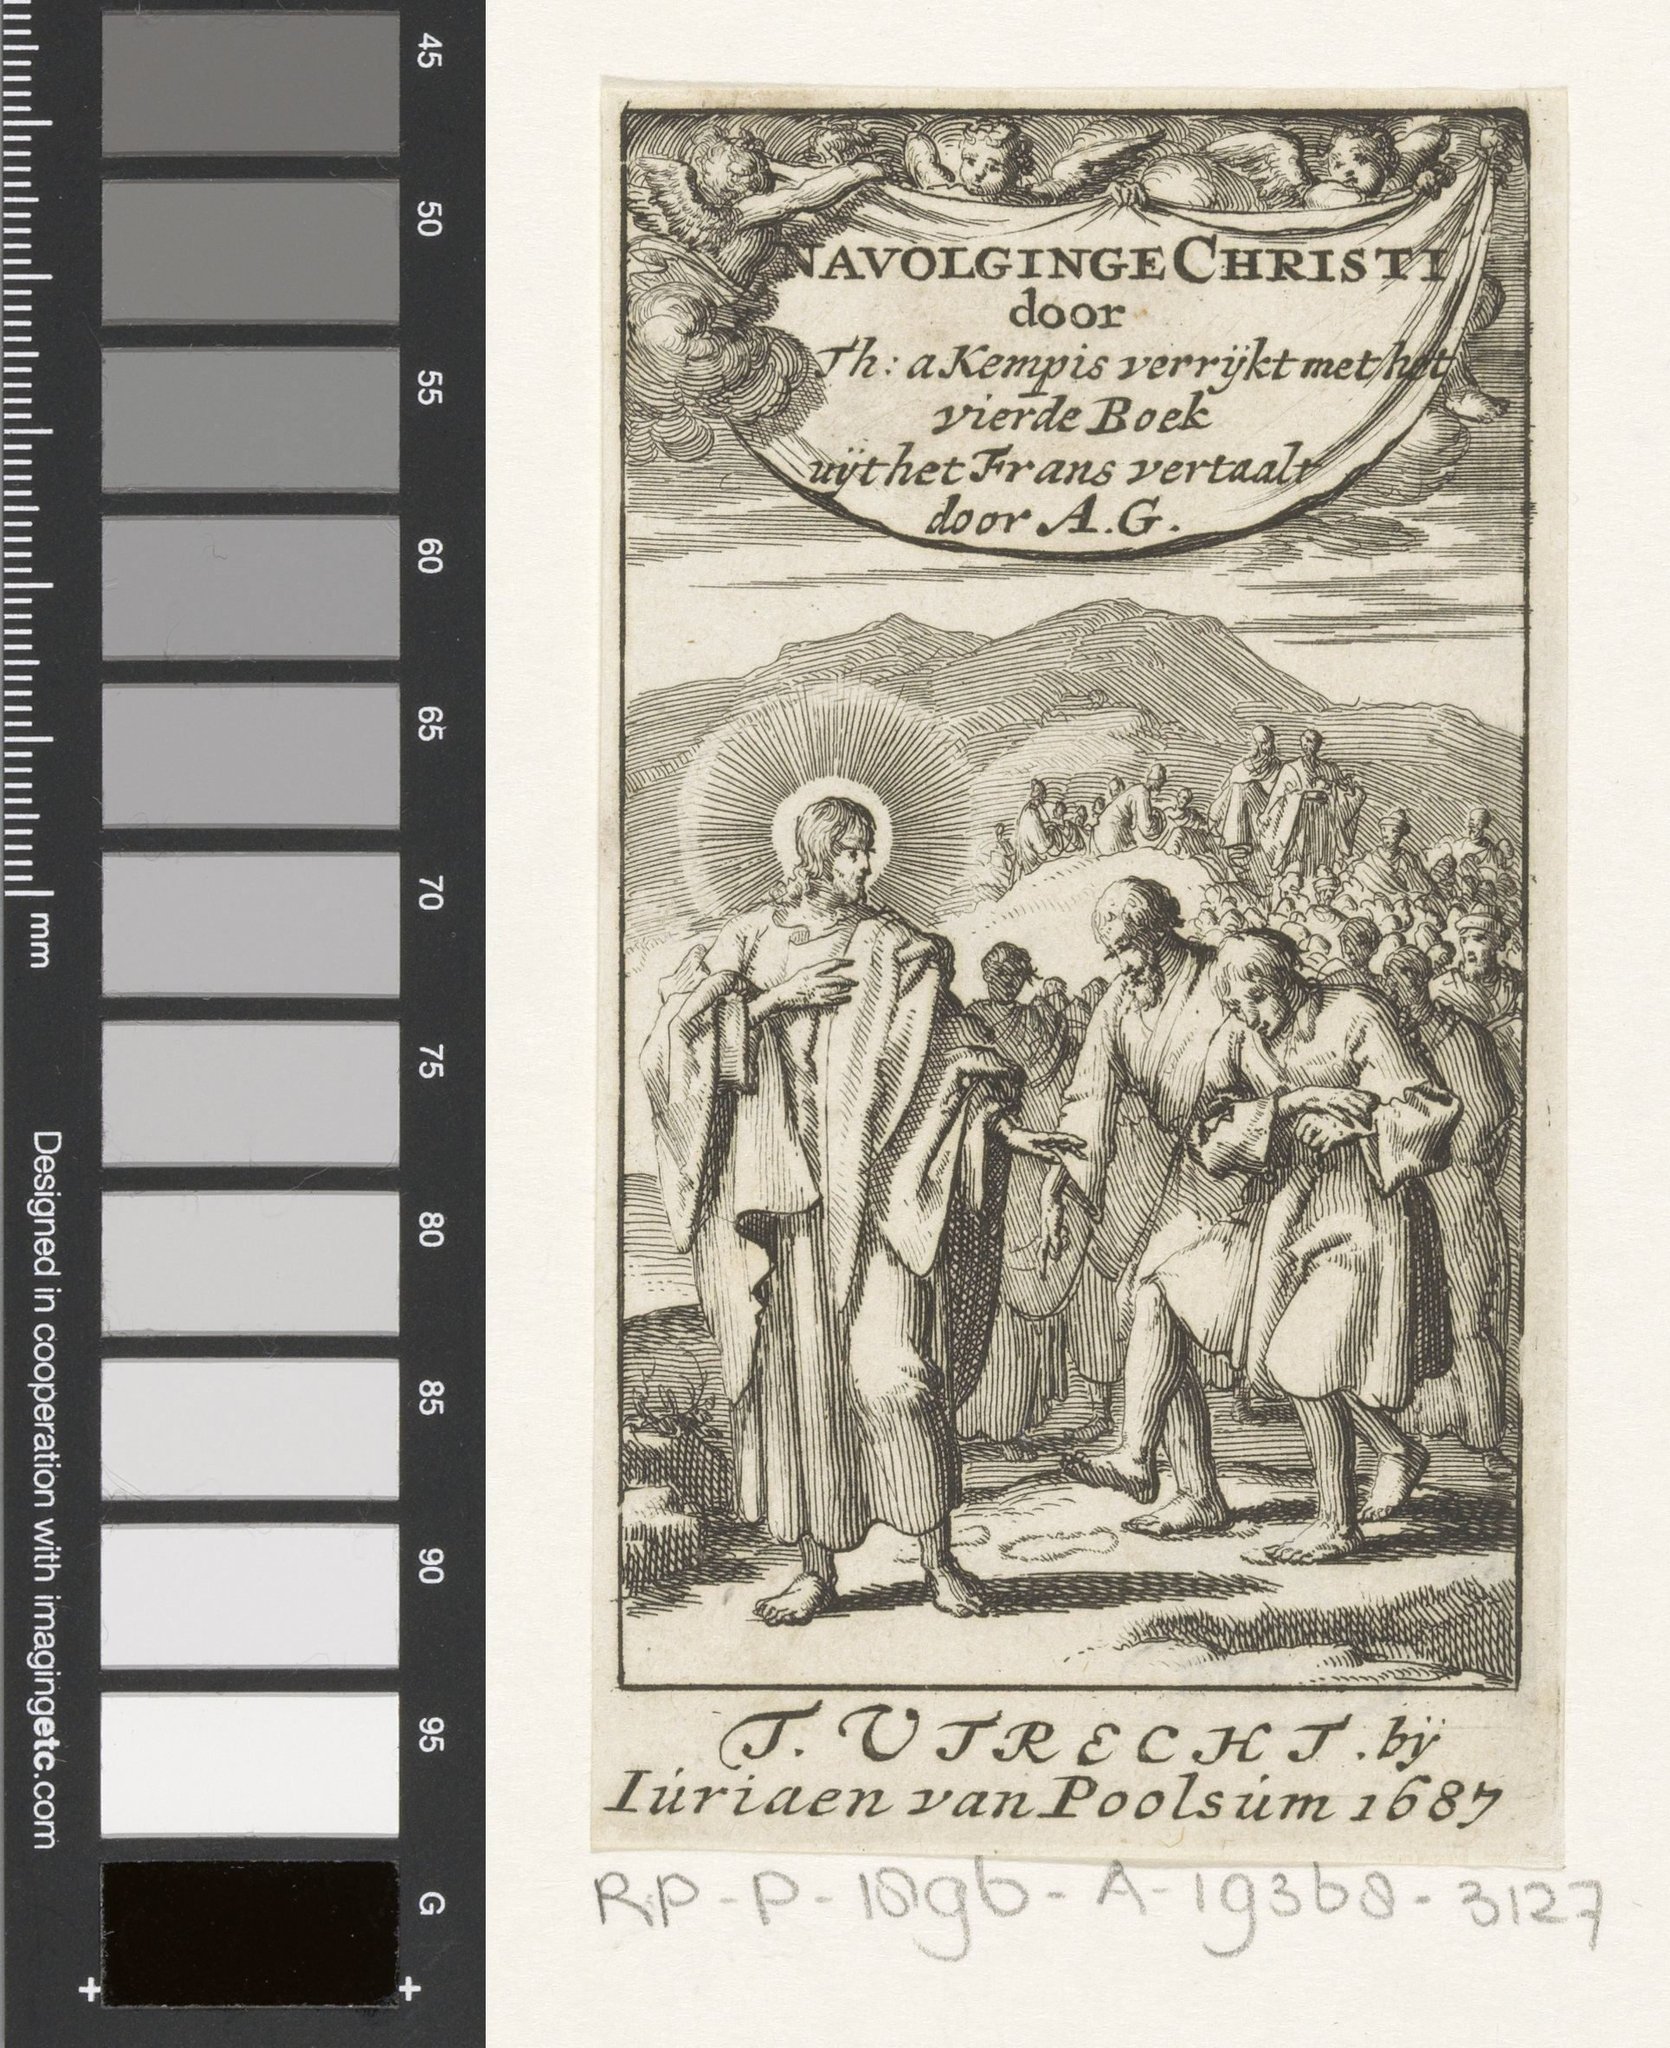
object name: print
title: Titelpagina voor: Thomas van Kempen, Navolginge Christi, 1687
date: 1687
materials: paper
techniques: etching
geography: amsterdam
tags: foot-print, track, christ as adult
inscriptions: collector's mark: Lugt 2228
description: Titelpagina voor: Kempen, Thomas van. Navolginge Christi. Utrecht: Poolsum, Jurriaen van, 1687.